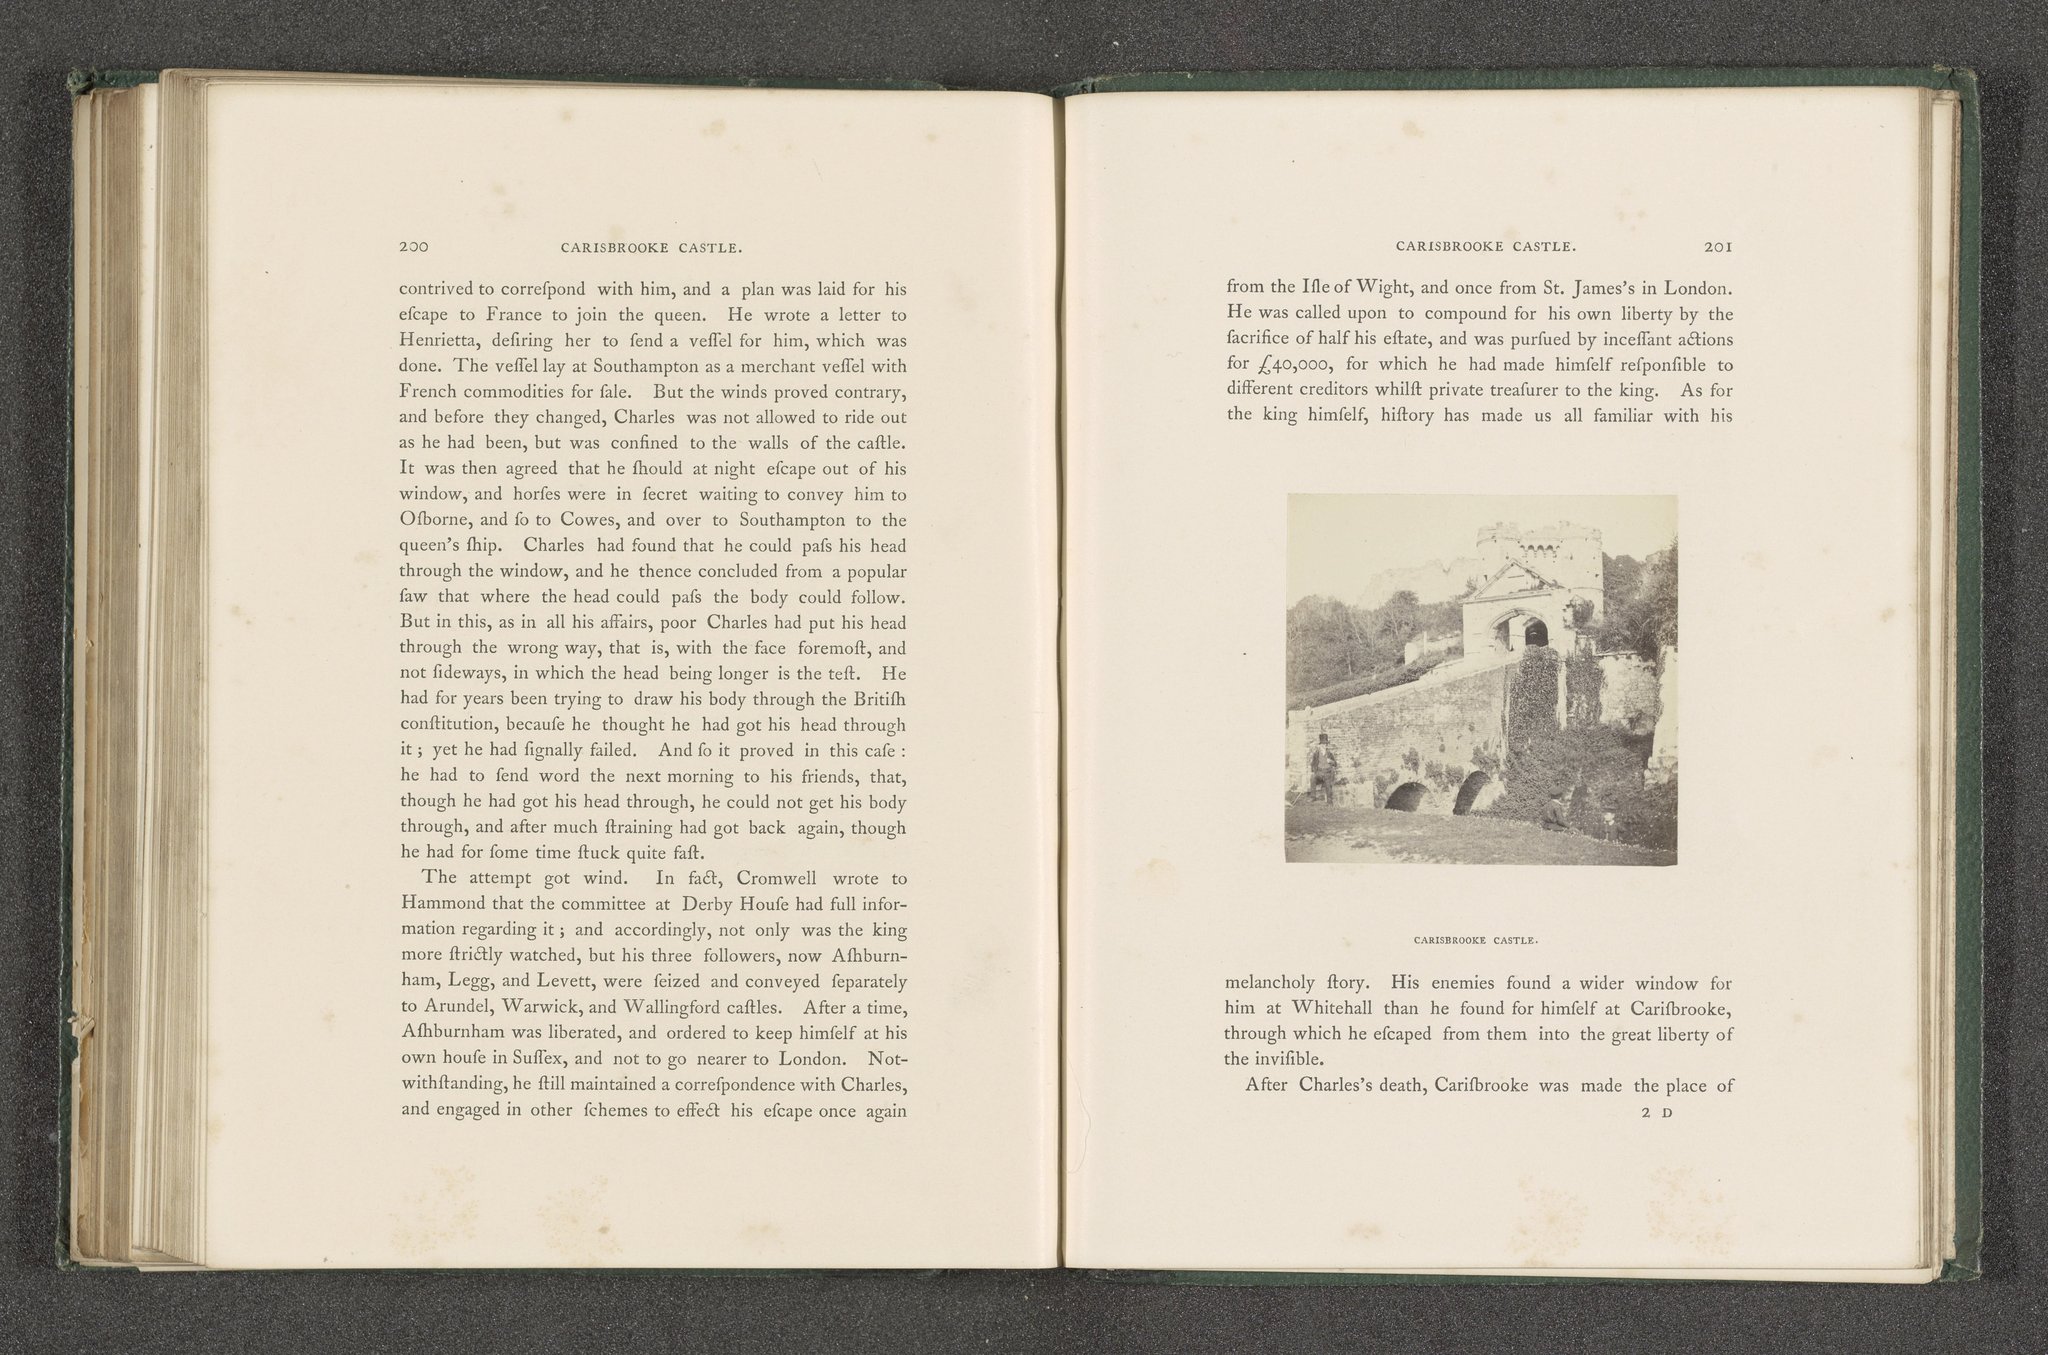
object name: page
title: Gezicht op Carisbrooke Castle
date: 1852-1862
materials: photographic support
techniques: albumen print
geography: carisbrooke castle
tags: gate, entrance, ruin of a dwelling, house, castle, etc.